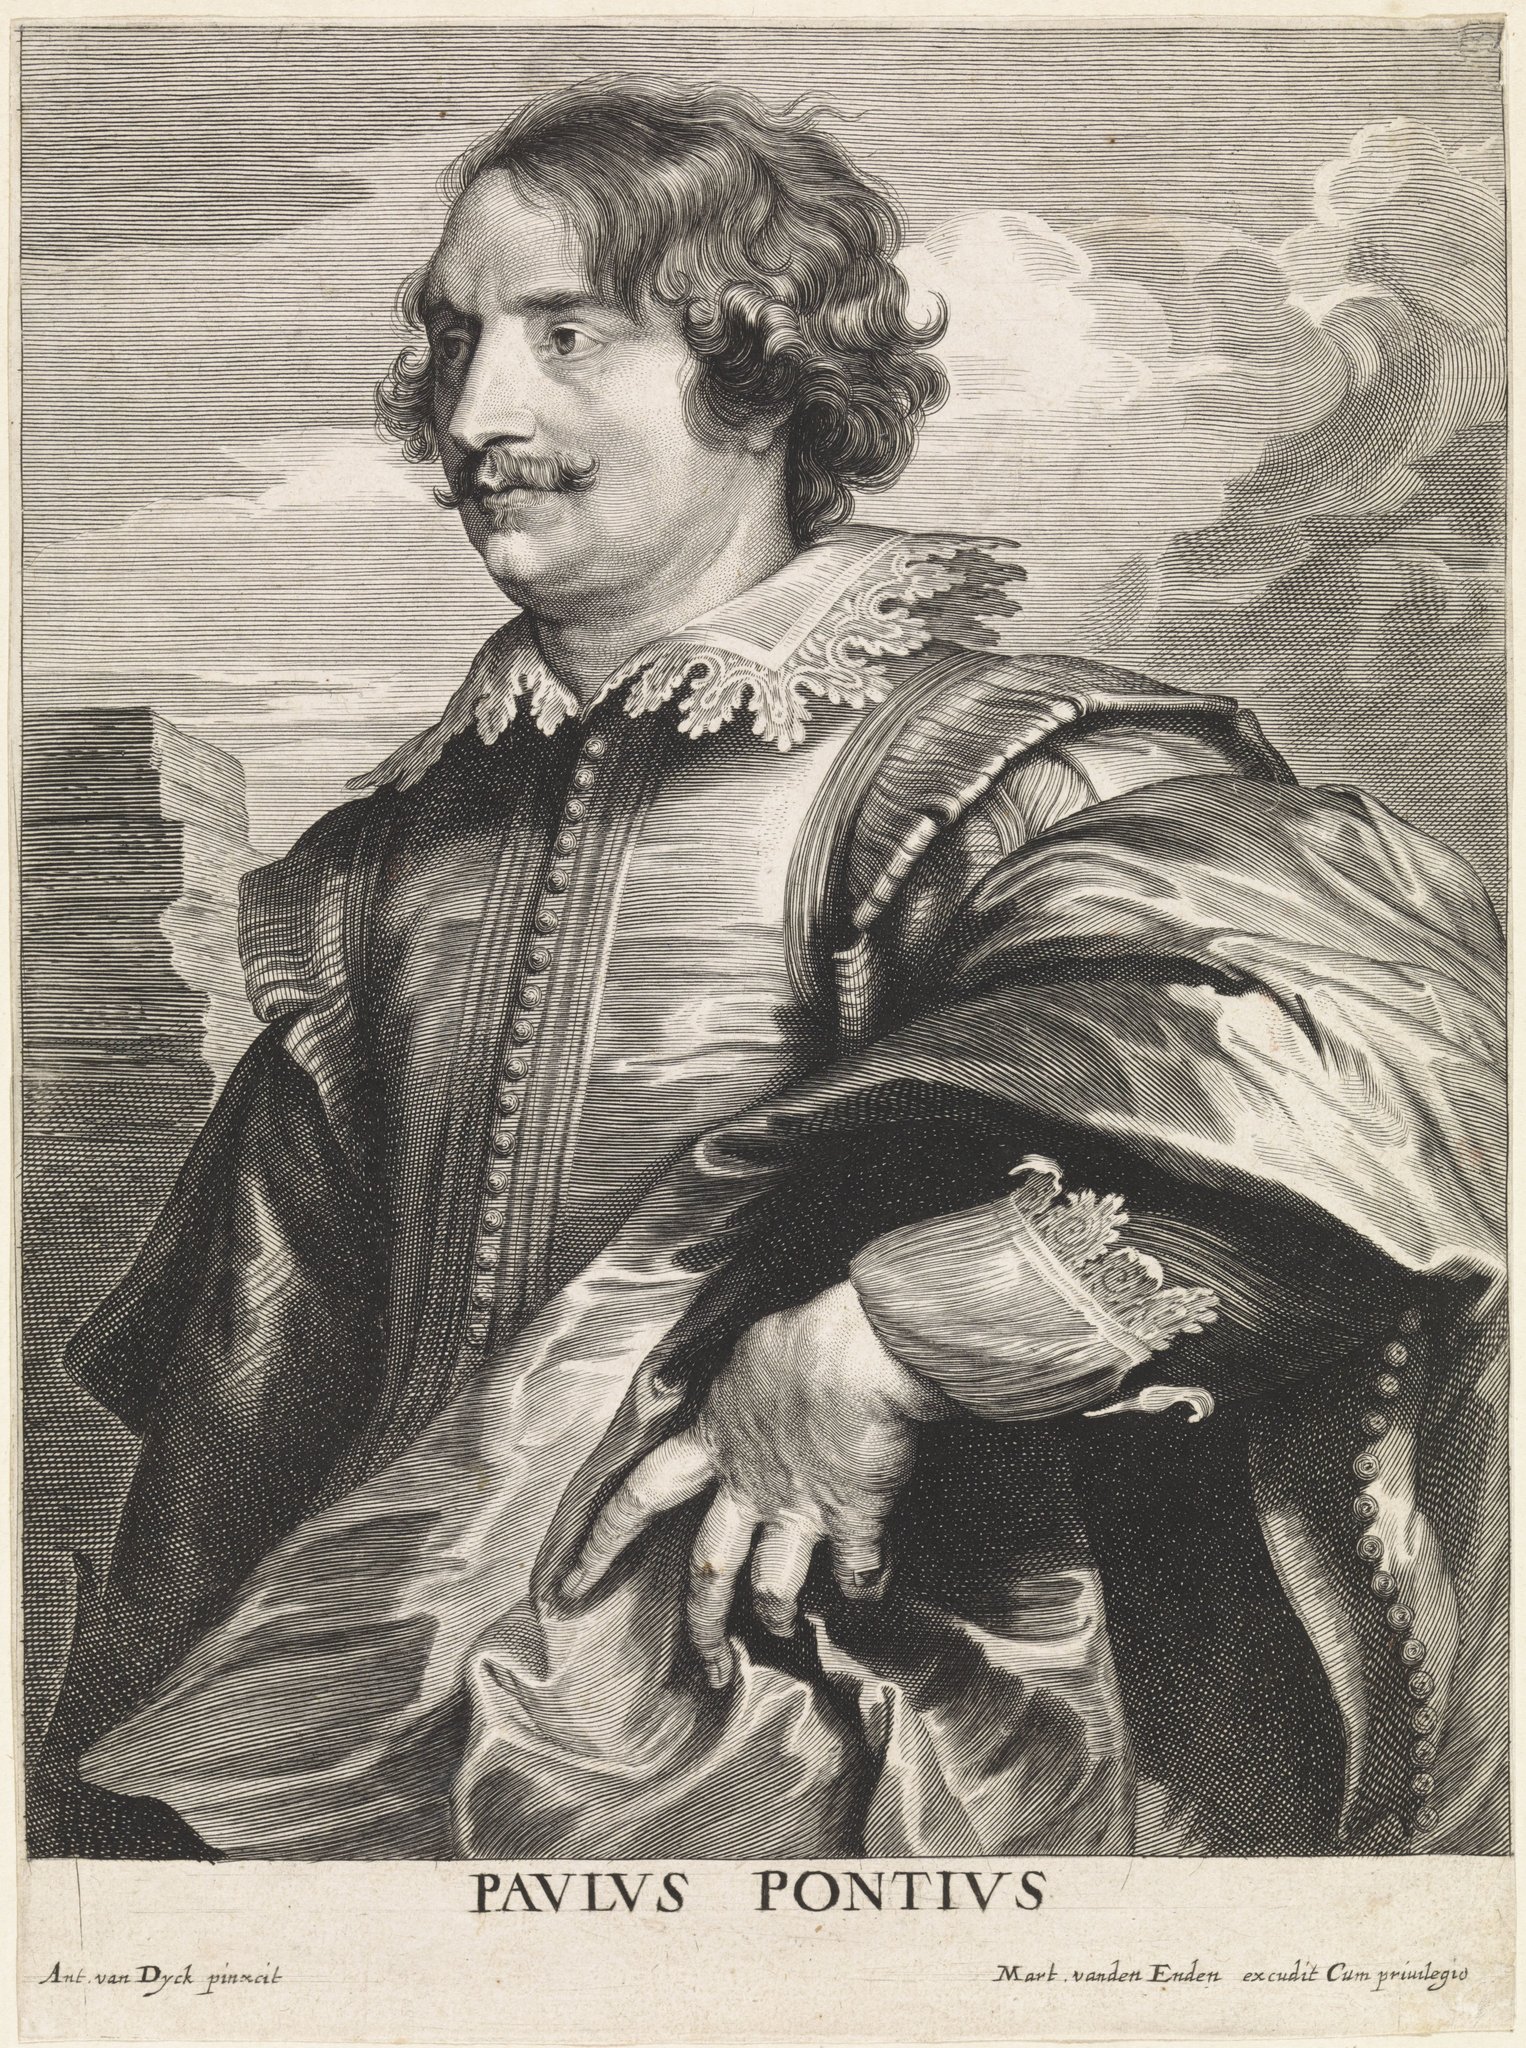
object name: print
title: Portret van de graveur Paulus Pontius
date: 1616-1657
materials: paper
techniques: engraving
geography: antwerp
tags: antwerp, print maker, draughtsman, paulus pontius, portrait, self-portrait of graphic artist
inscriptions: collector's mark: Lugt 240